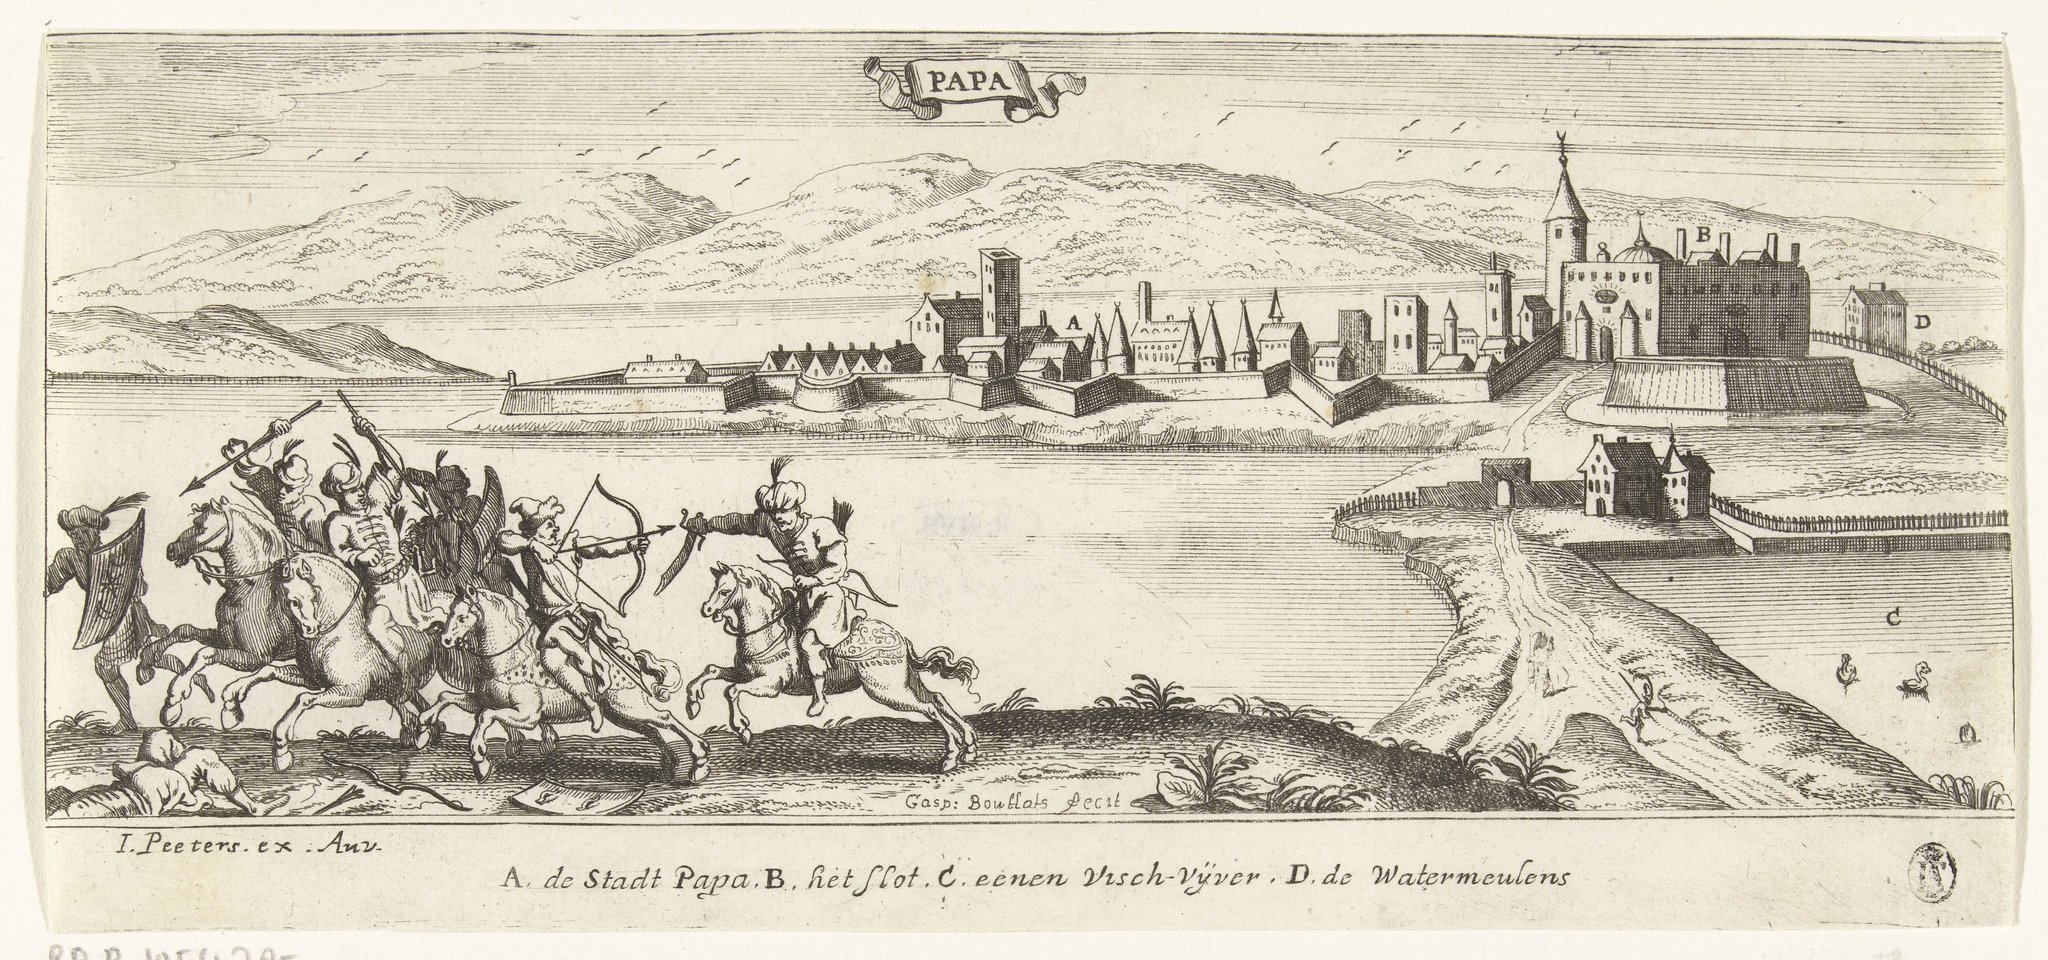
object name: print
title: Korte beschryvinghe, en de aen-wysinghe der plaetsen in desen boeck, met hunnen teghen woordighen standt, pertinentelijk uyt-ghebeldt, in Oostenryck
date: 1686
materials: paper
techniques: etching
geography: antwerp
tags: prospect of city, town panorama, silhouette of city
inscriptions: collector's mark: Lugt 2228, collector's mark: Lugt 2760, collector's mark: Lugt 971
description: Gezicht op de stad Pápa. Op de voorgrond, buiten de stadsmuren, bevechten ottomaanse ruiters elkaar. Boven het stadsgezicht een cartouche met de naam van de stad. De prent heeft een Nederlands onderschrift met verwijzingen naar gebouwen op de prent.